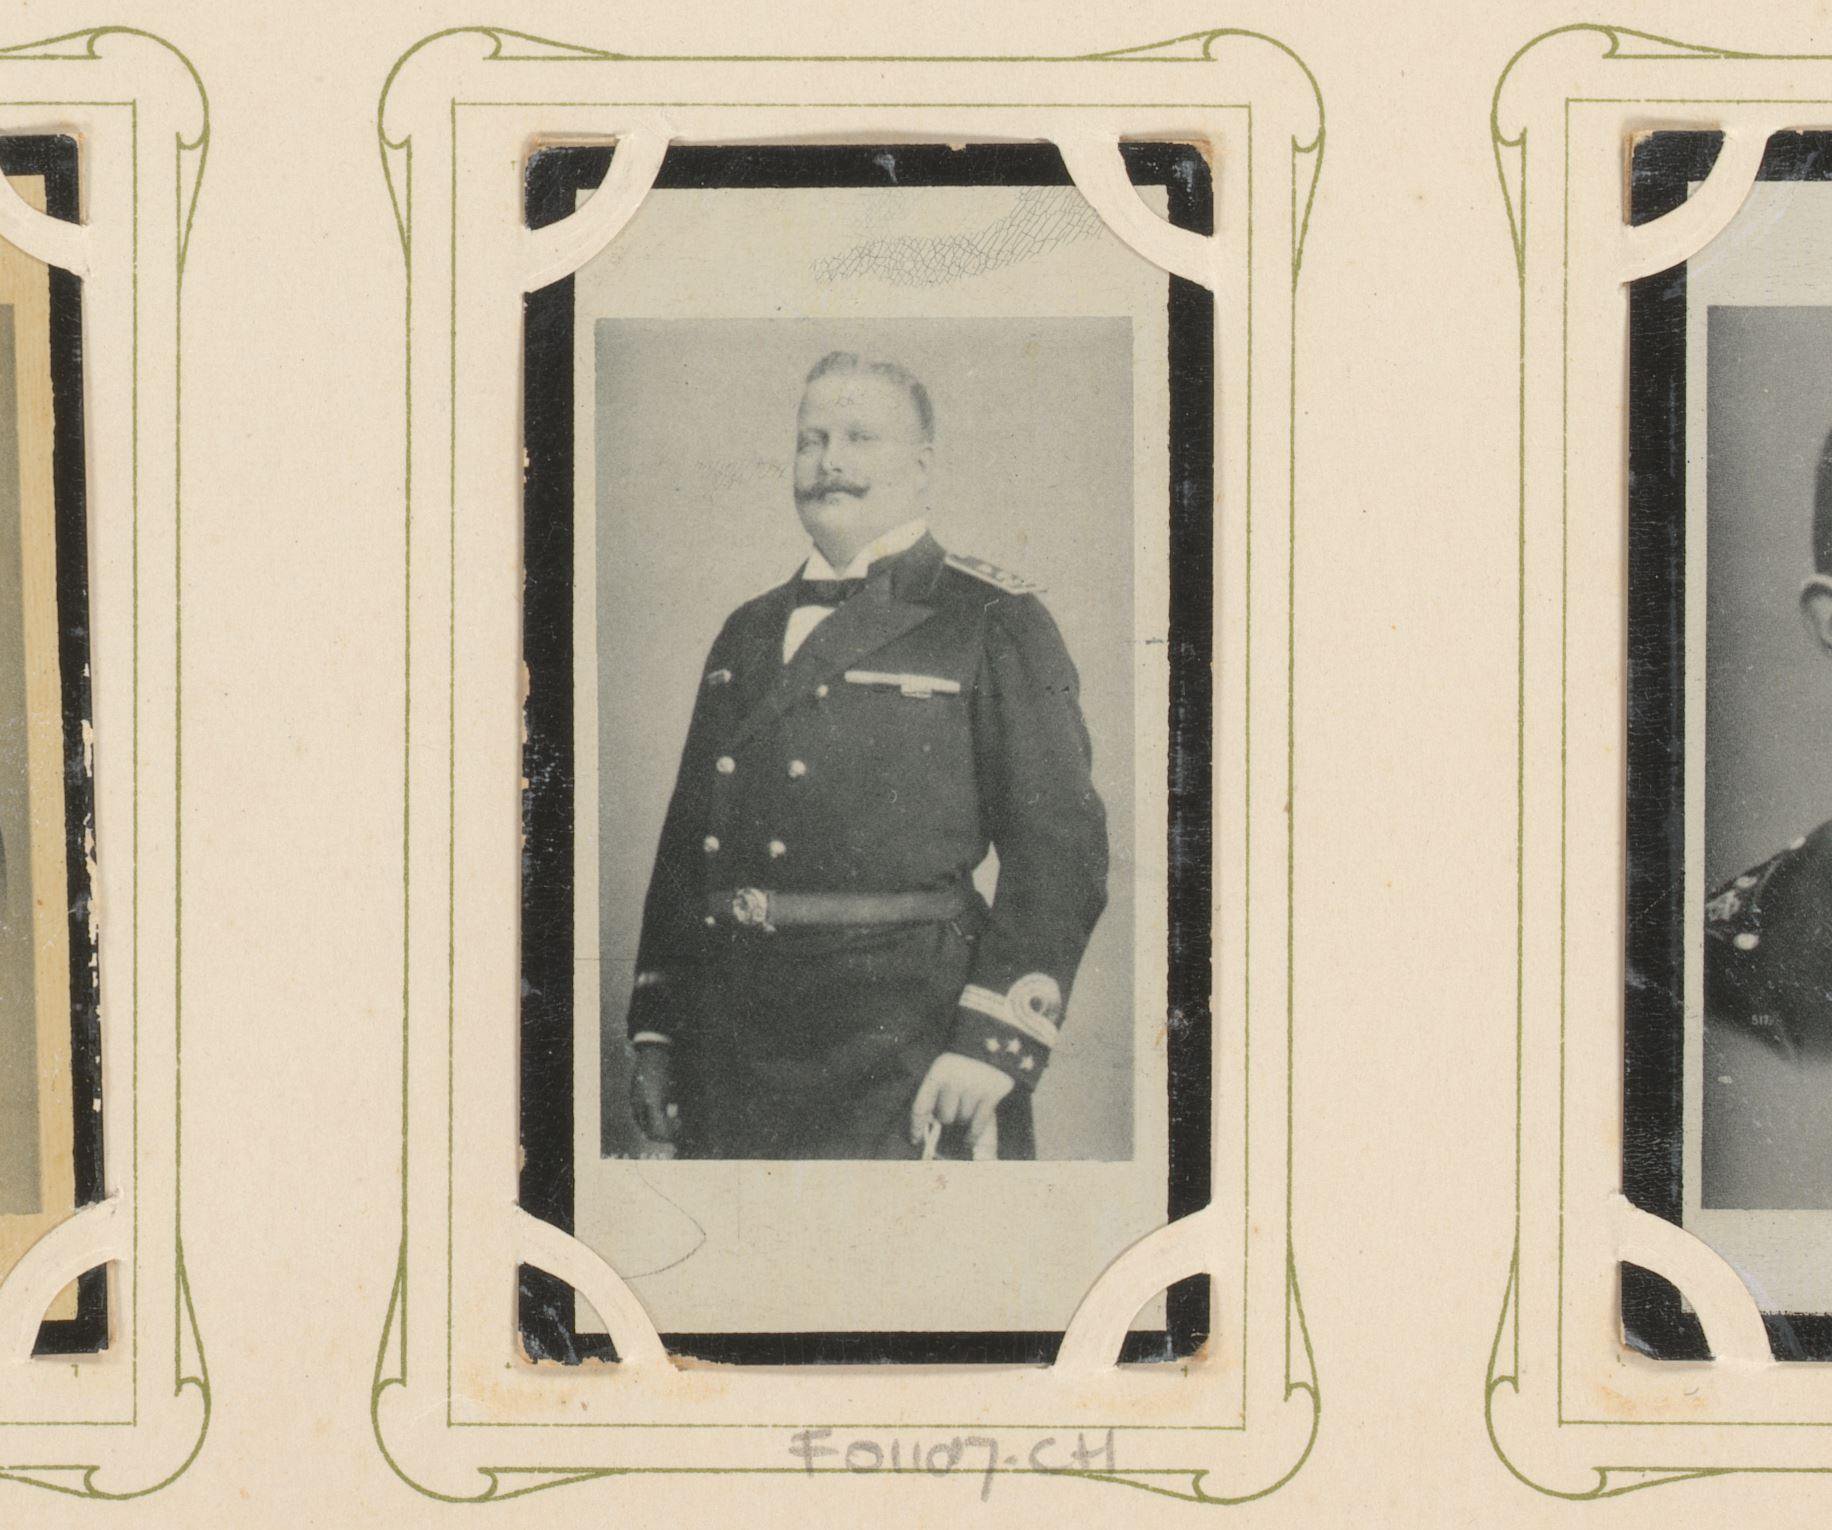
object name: album leaf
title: Portret van koning Karel I van Portugal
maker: Anonymous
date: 1905-1906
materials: paper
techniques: photograph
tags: historical persons, king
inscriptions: inscription: ‘No. 11./ Koning Karel I van Portugal.’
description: Deze prent maakt deel uit van een album.